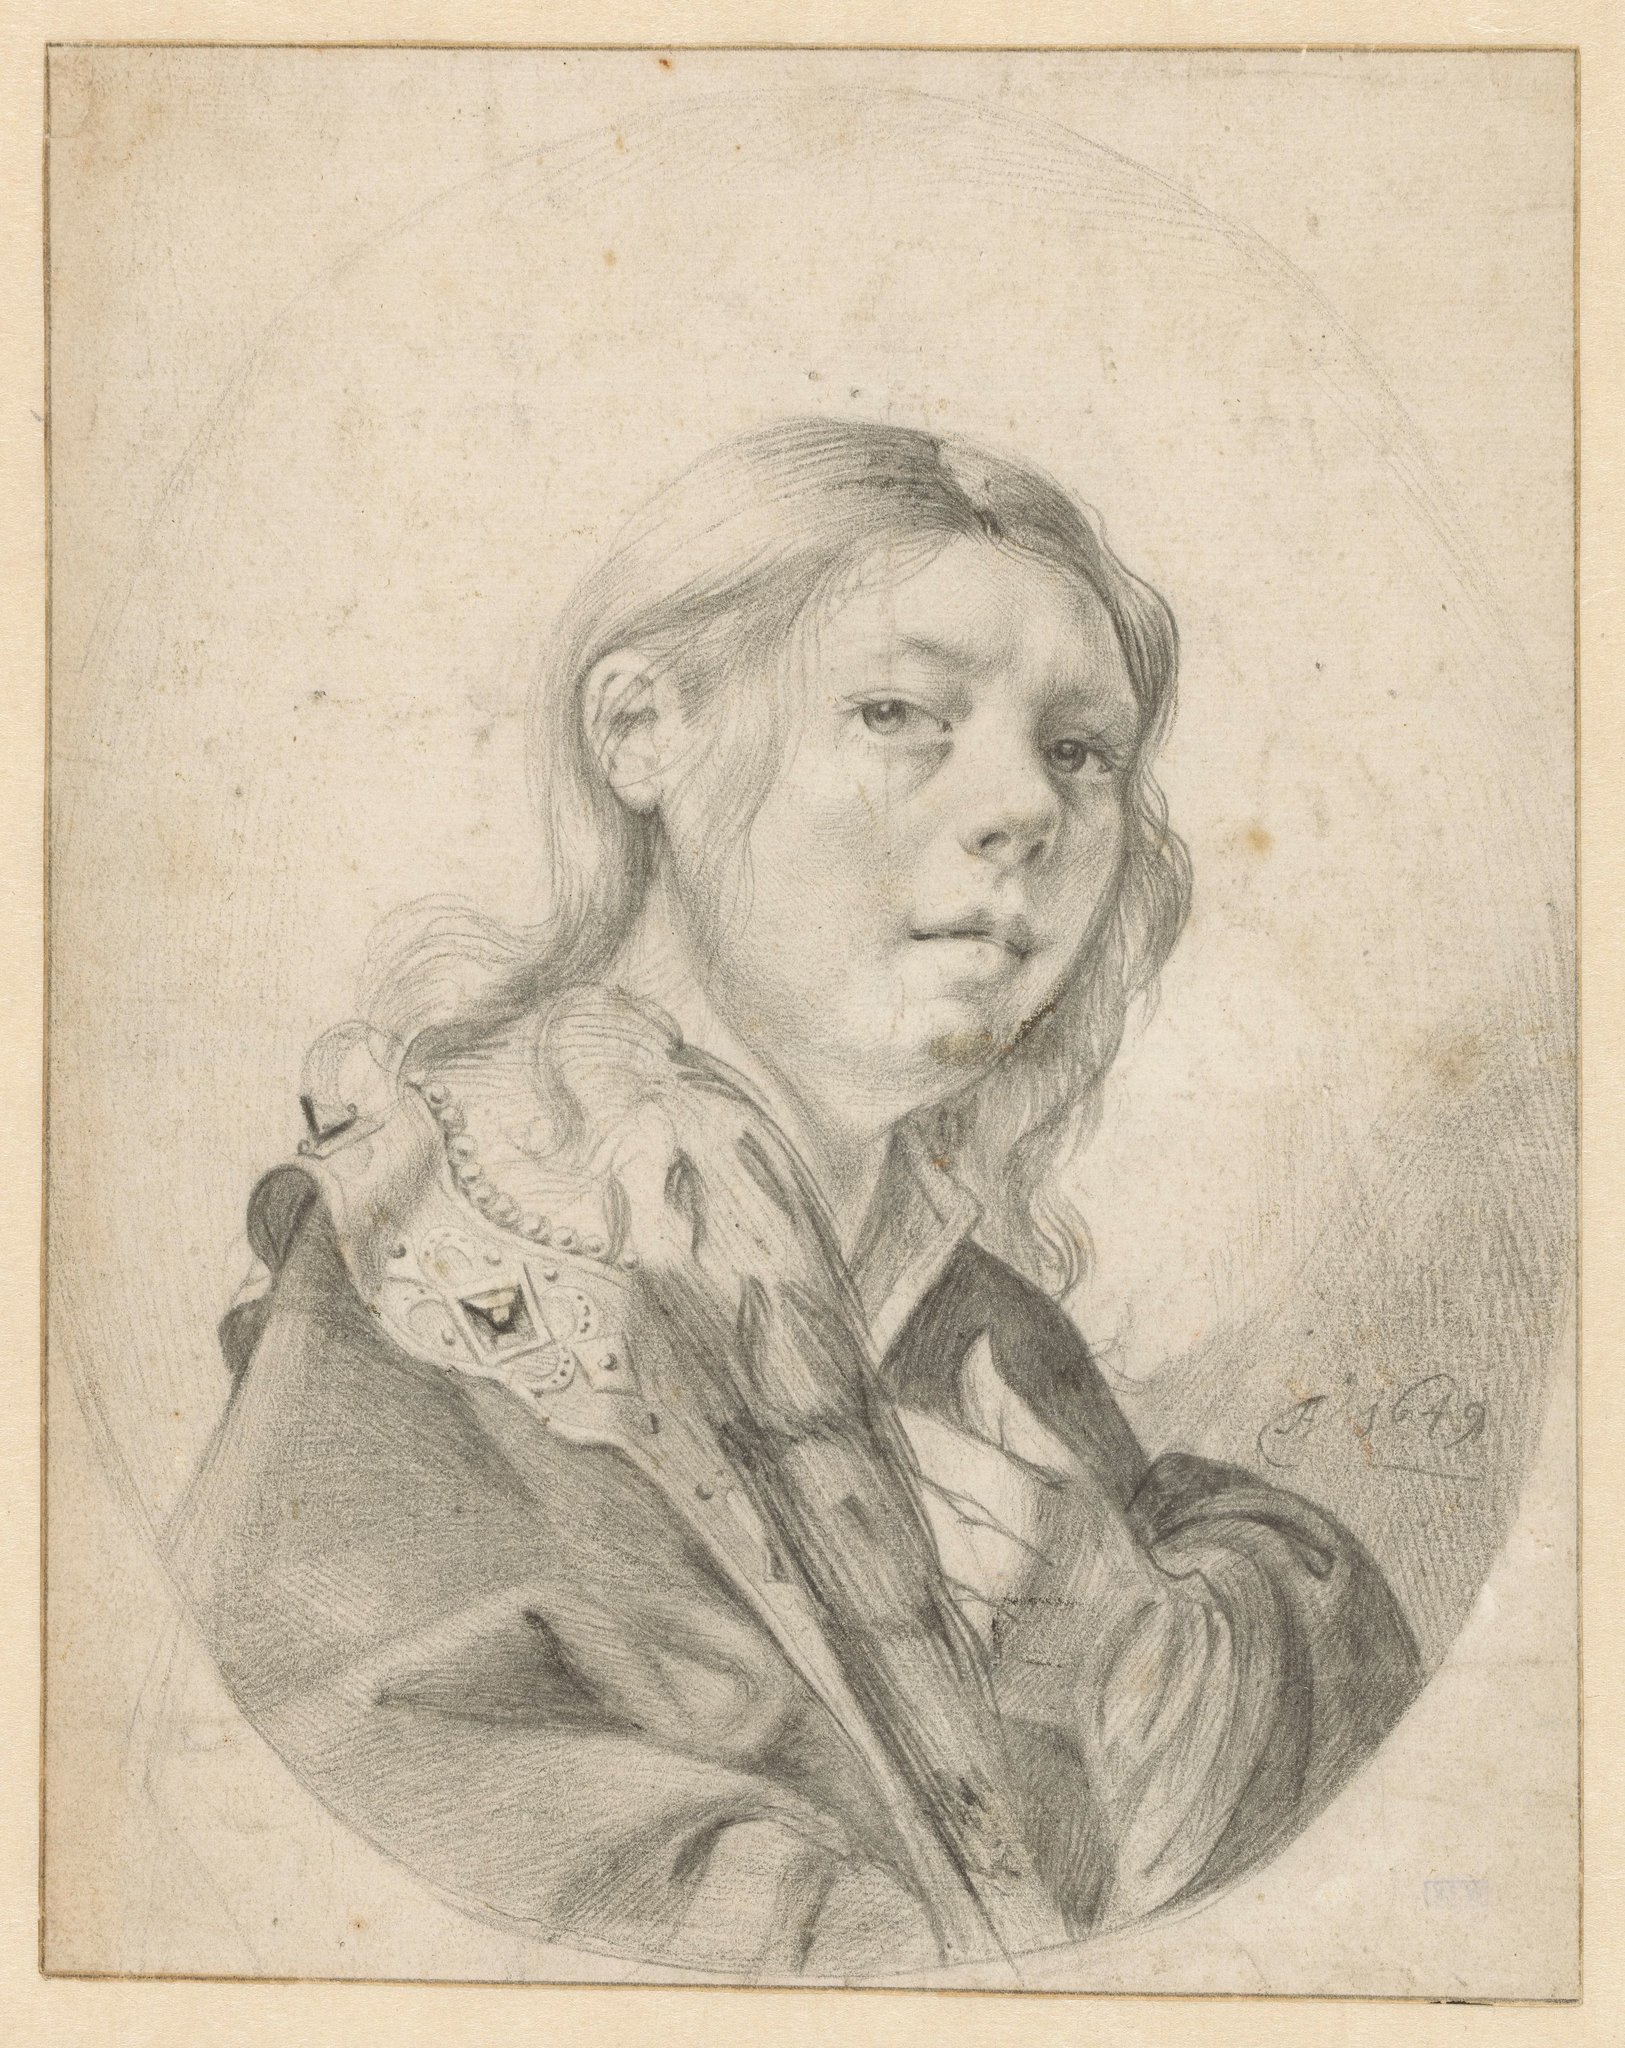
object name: drawing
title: Zelfportret van Dirck Helmbreeker in een ovaal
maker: dirck helmbreeker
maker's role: draughtsman, painter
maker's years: 1633-1696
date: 1649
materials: paper, pencil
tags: haarlem, rome, draughtsman, dirck helmbreeker, adult man, historical persons, portrait, self-portrait of artist